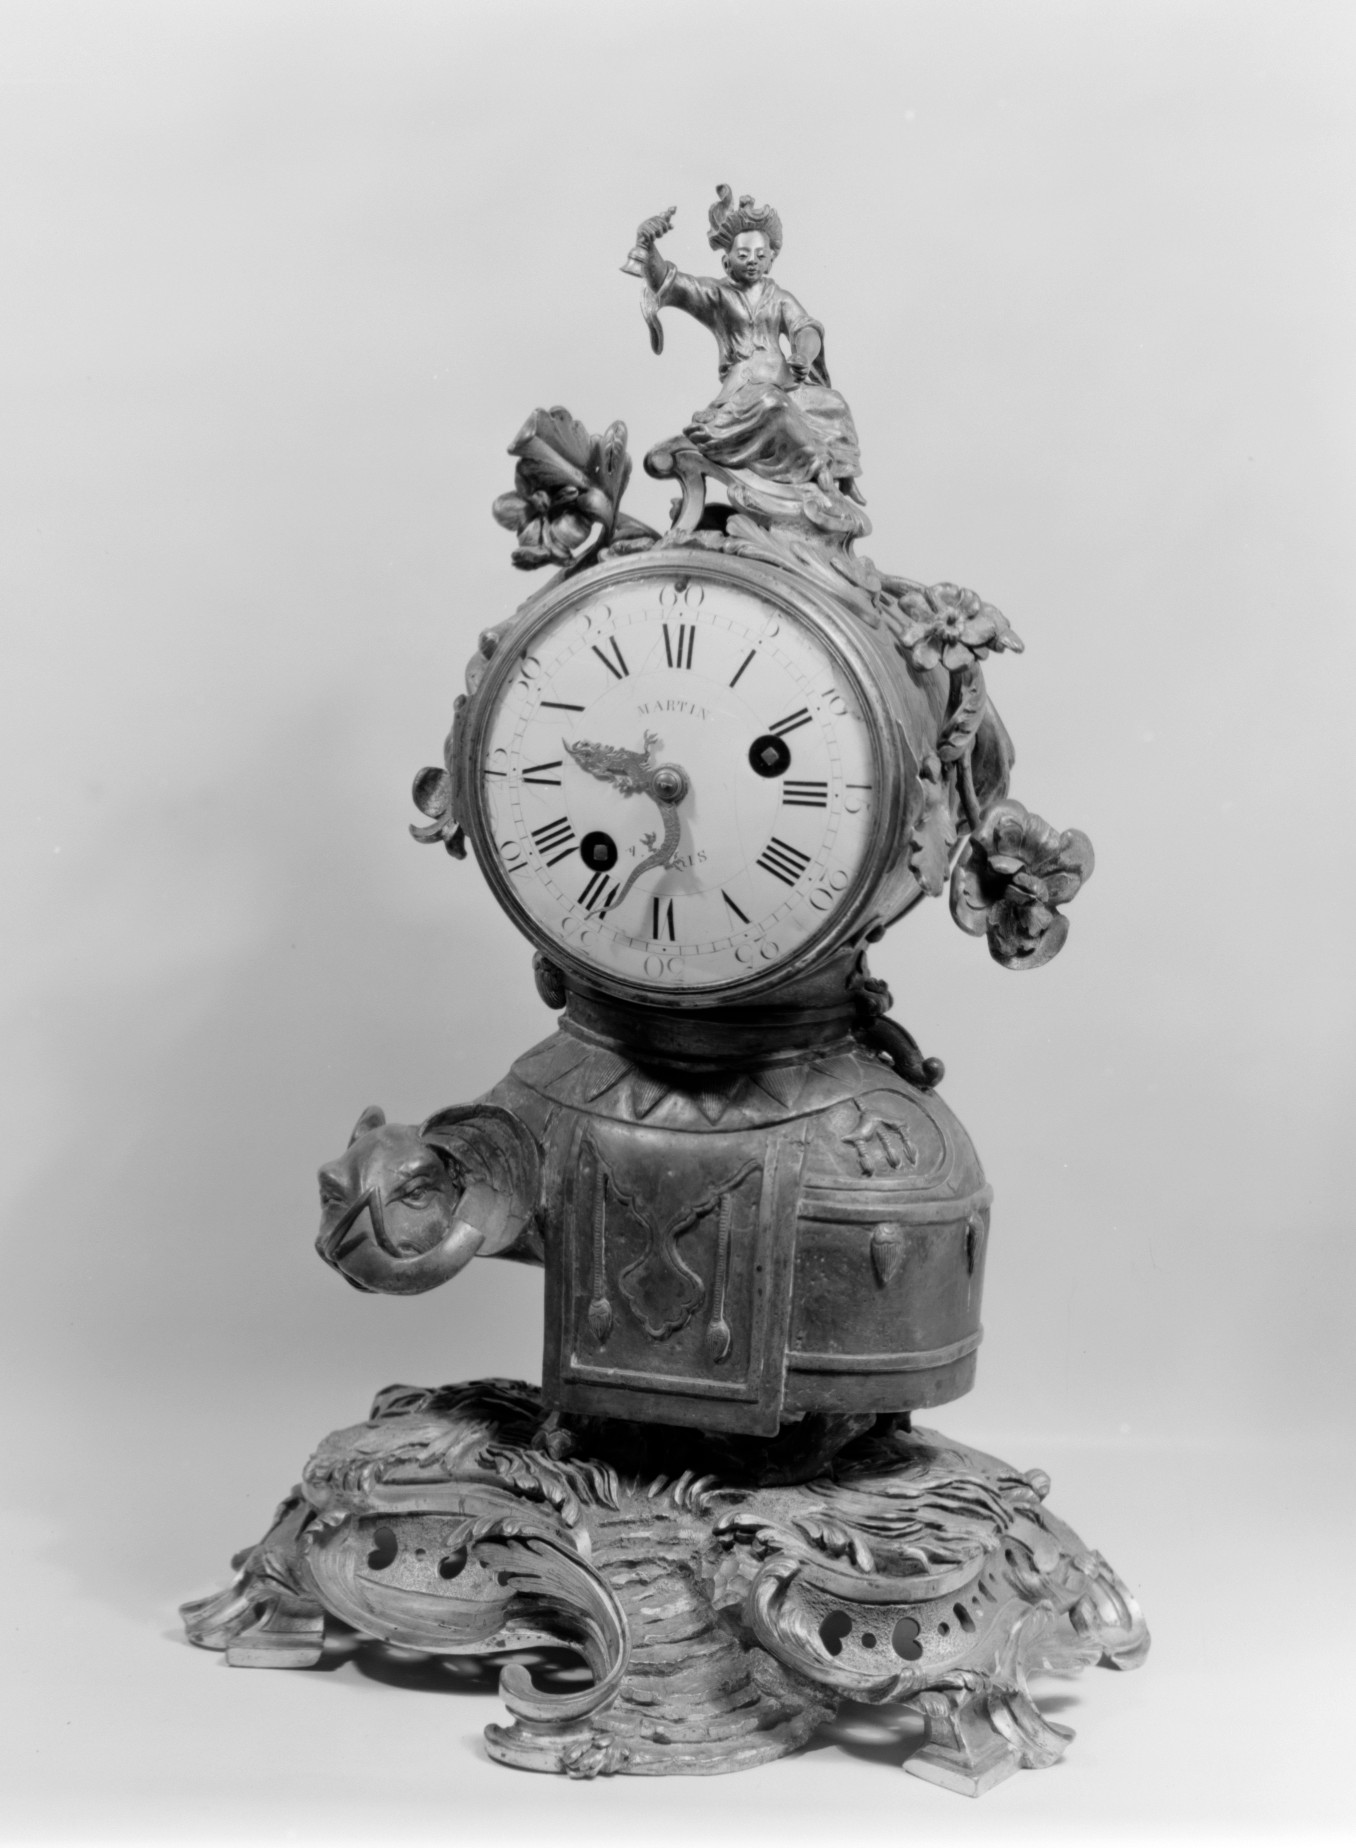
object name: mantel clock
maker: martin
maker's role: maker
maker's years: 1725-1825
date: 1734-1766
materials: bronze, gilt bronze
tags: human figures,animals,lizards